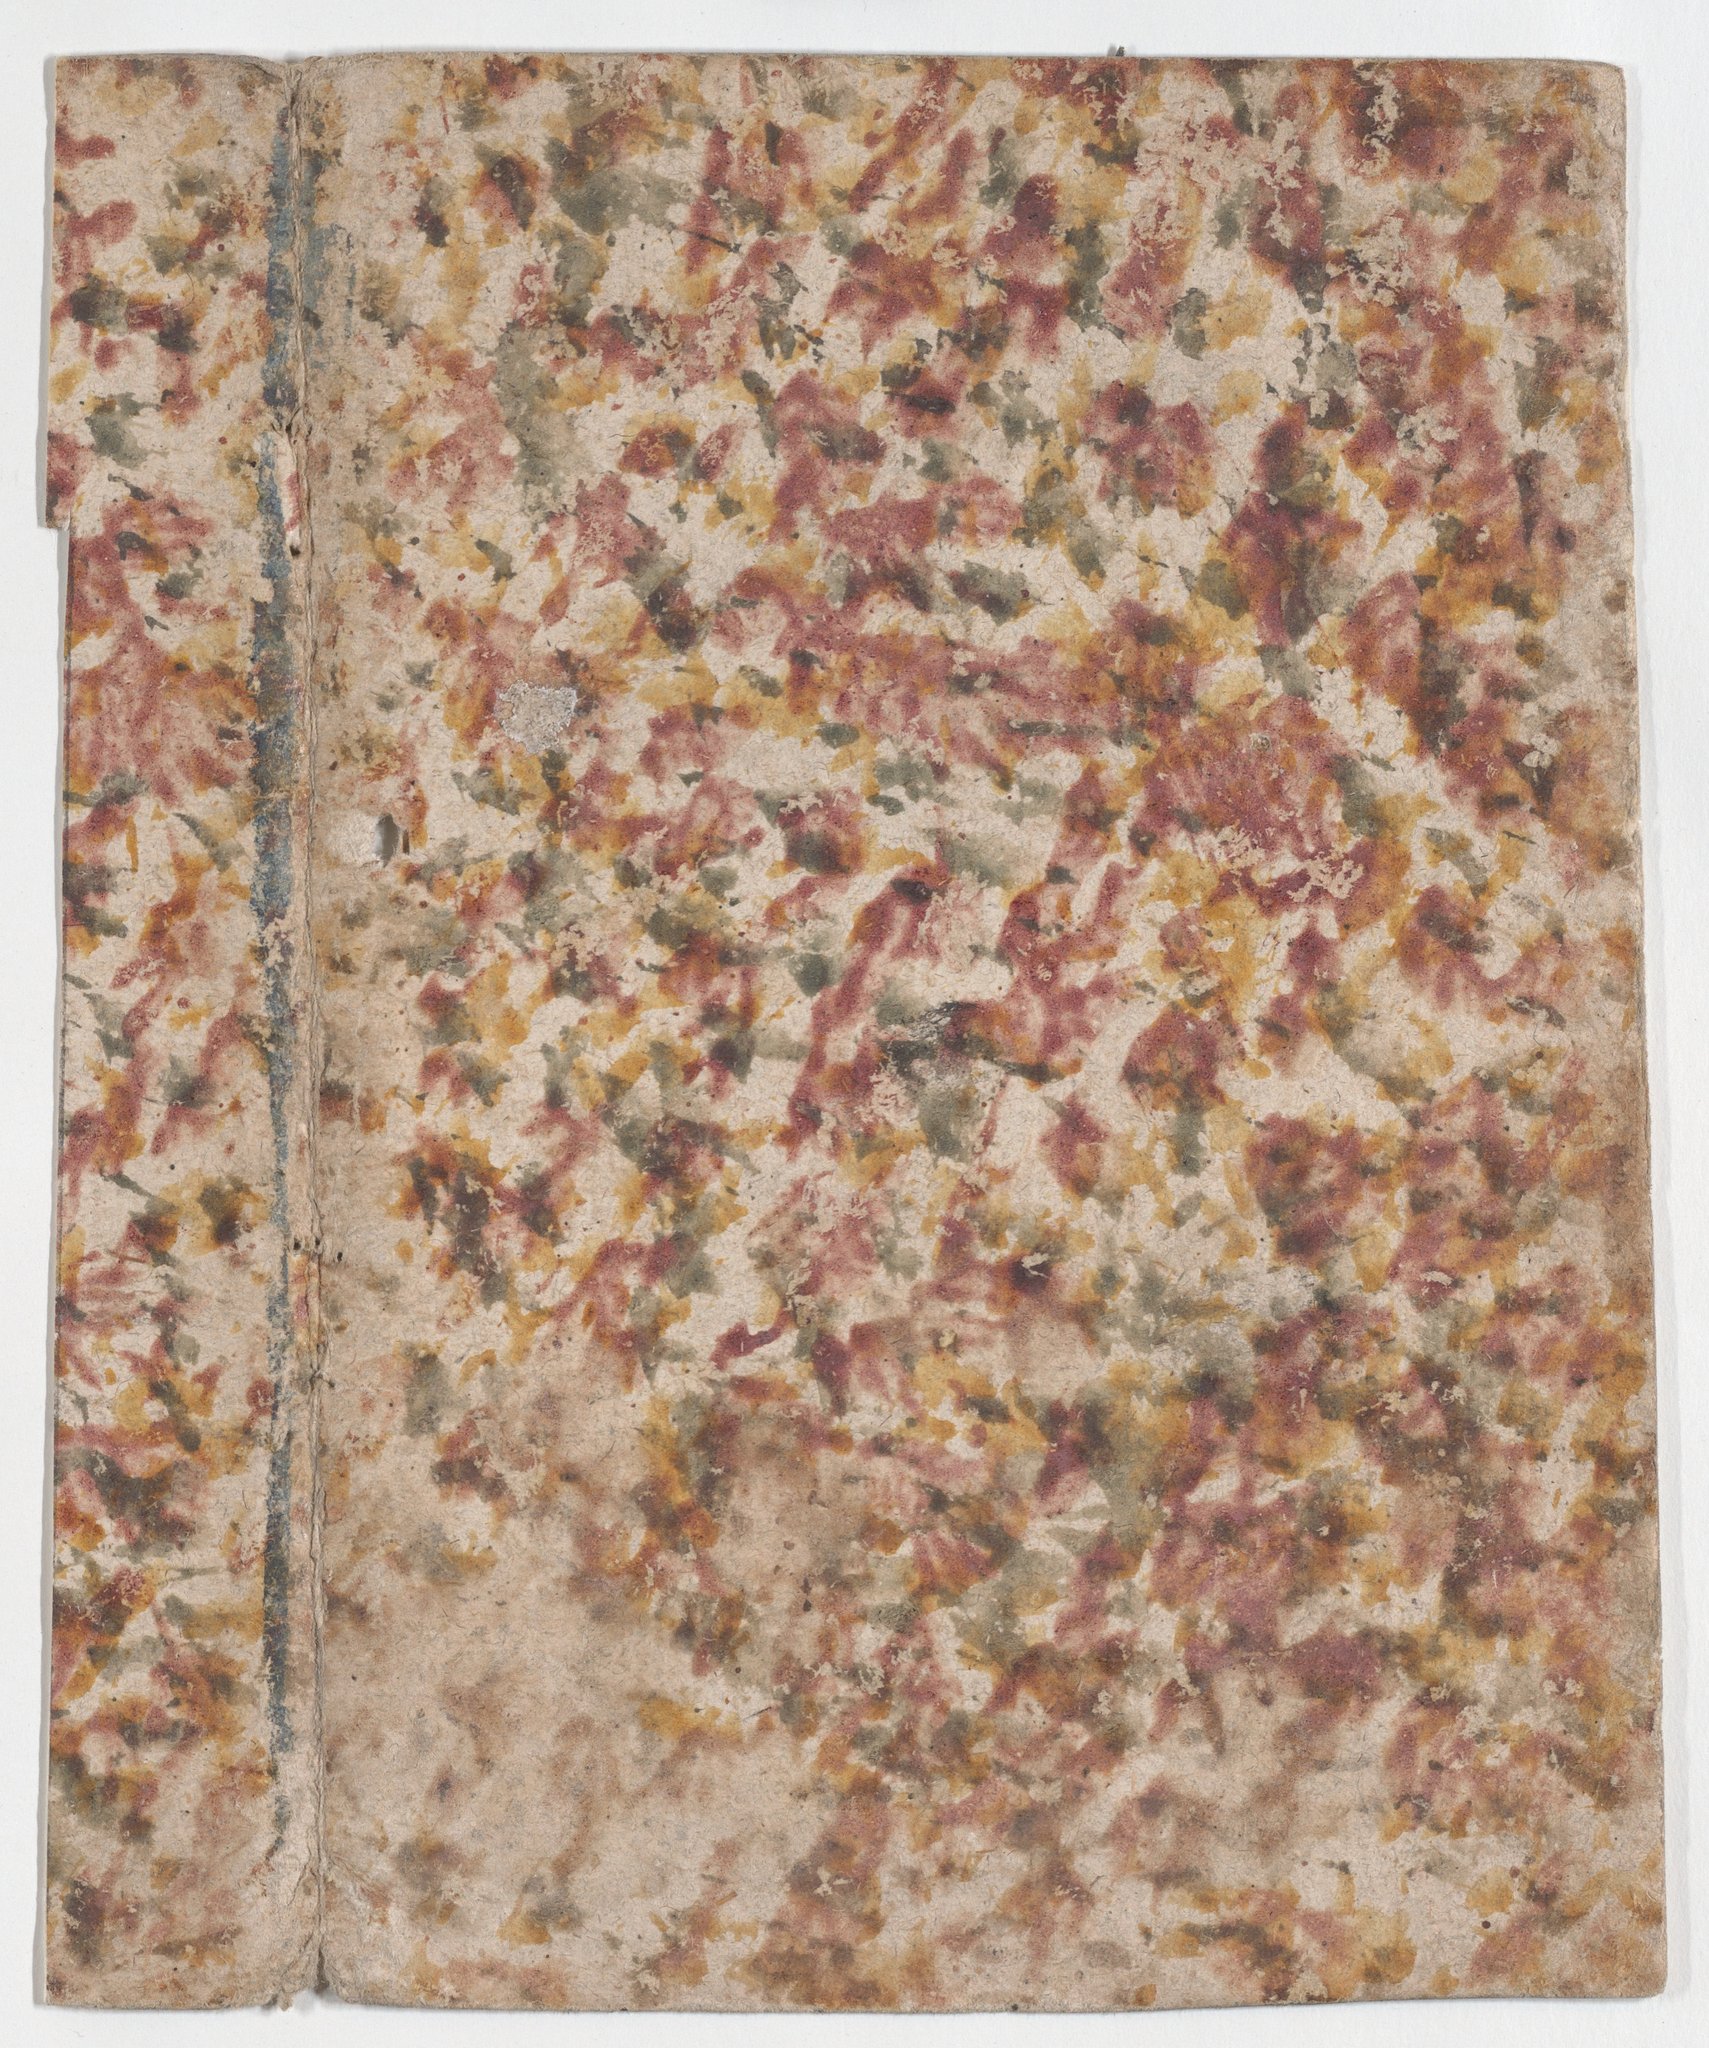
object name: print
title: Book cover with overall splotchy pattern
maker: Anonymous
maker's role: artist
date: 1801-1900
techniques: relief print